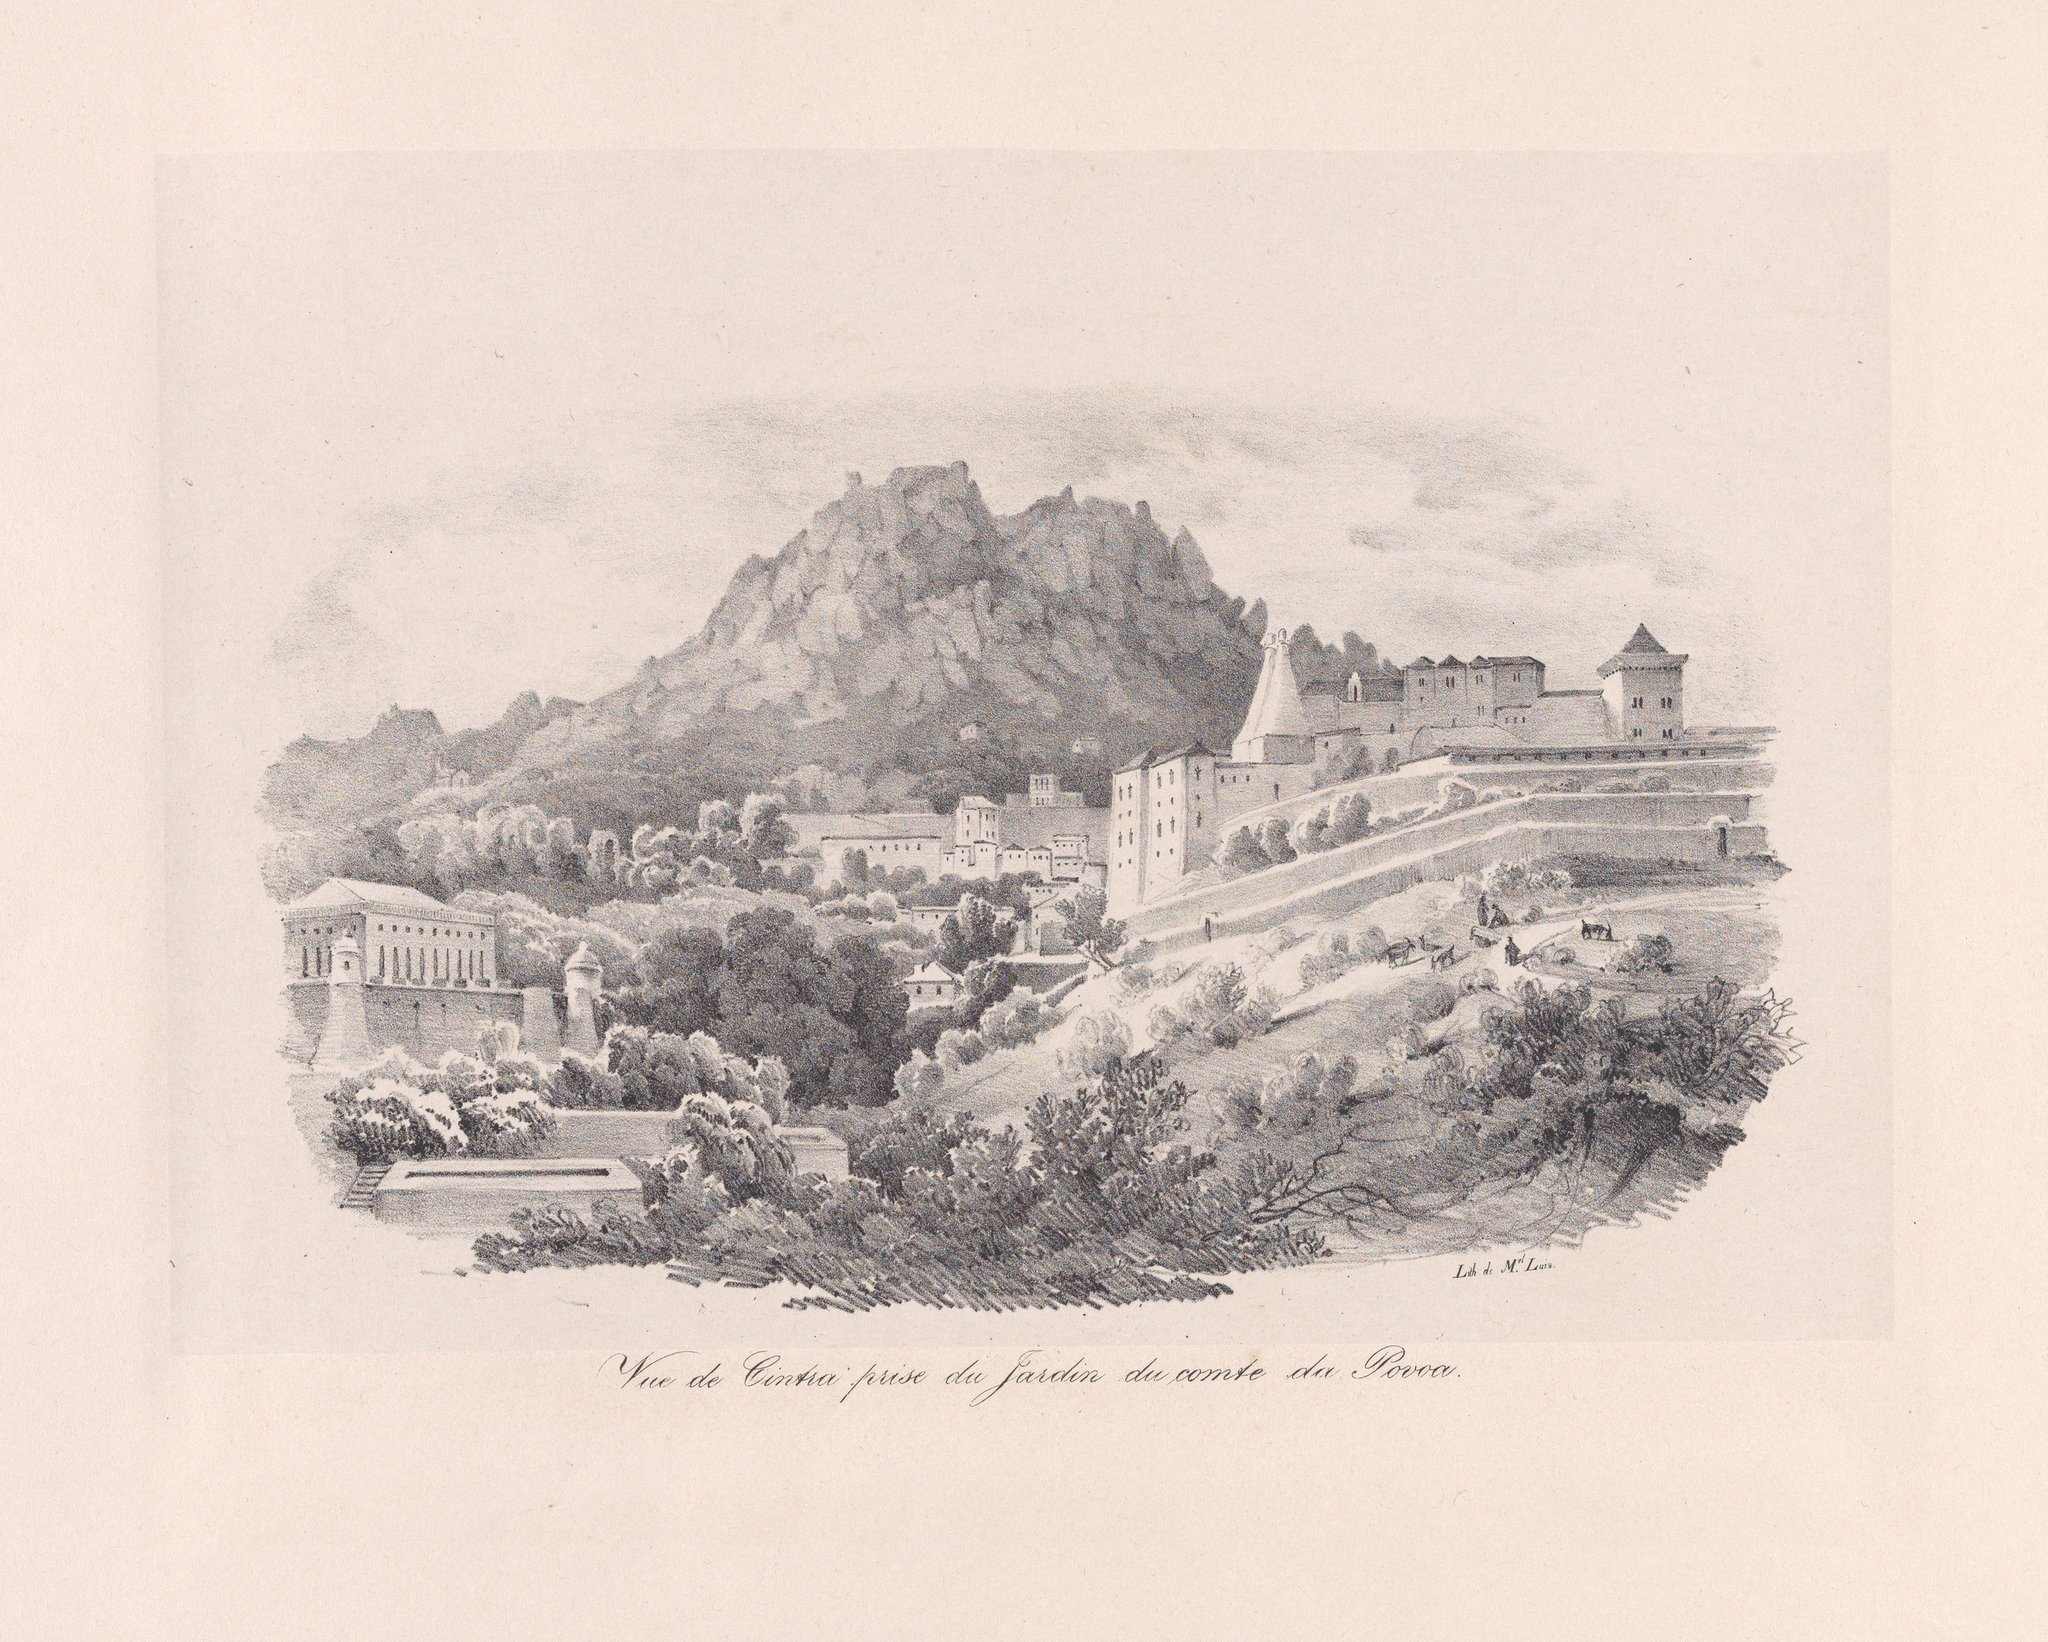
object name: print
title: View of the Sintra from the garden of the Comte de Povoa, National Palace in the background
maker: clementine de brelaz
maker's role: artist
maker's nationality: portuguese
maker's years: 1811-1892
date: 1840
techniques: printmaking, lithograph